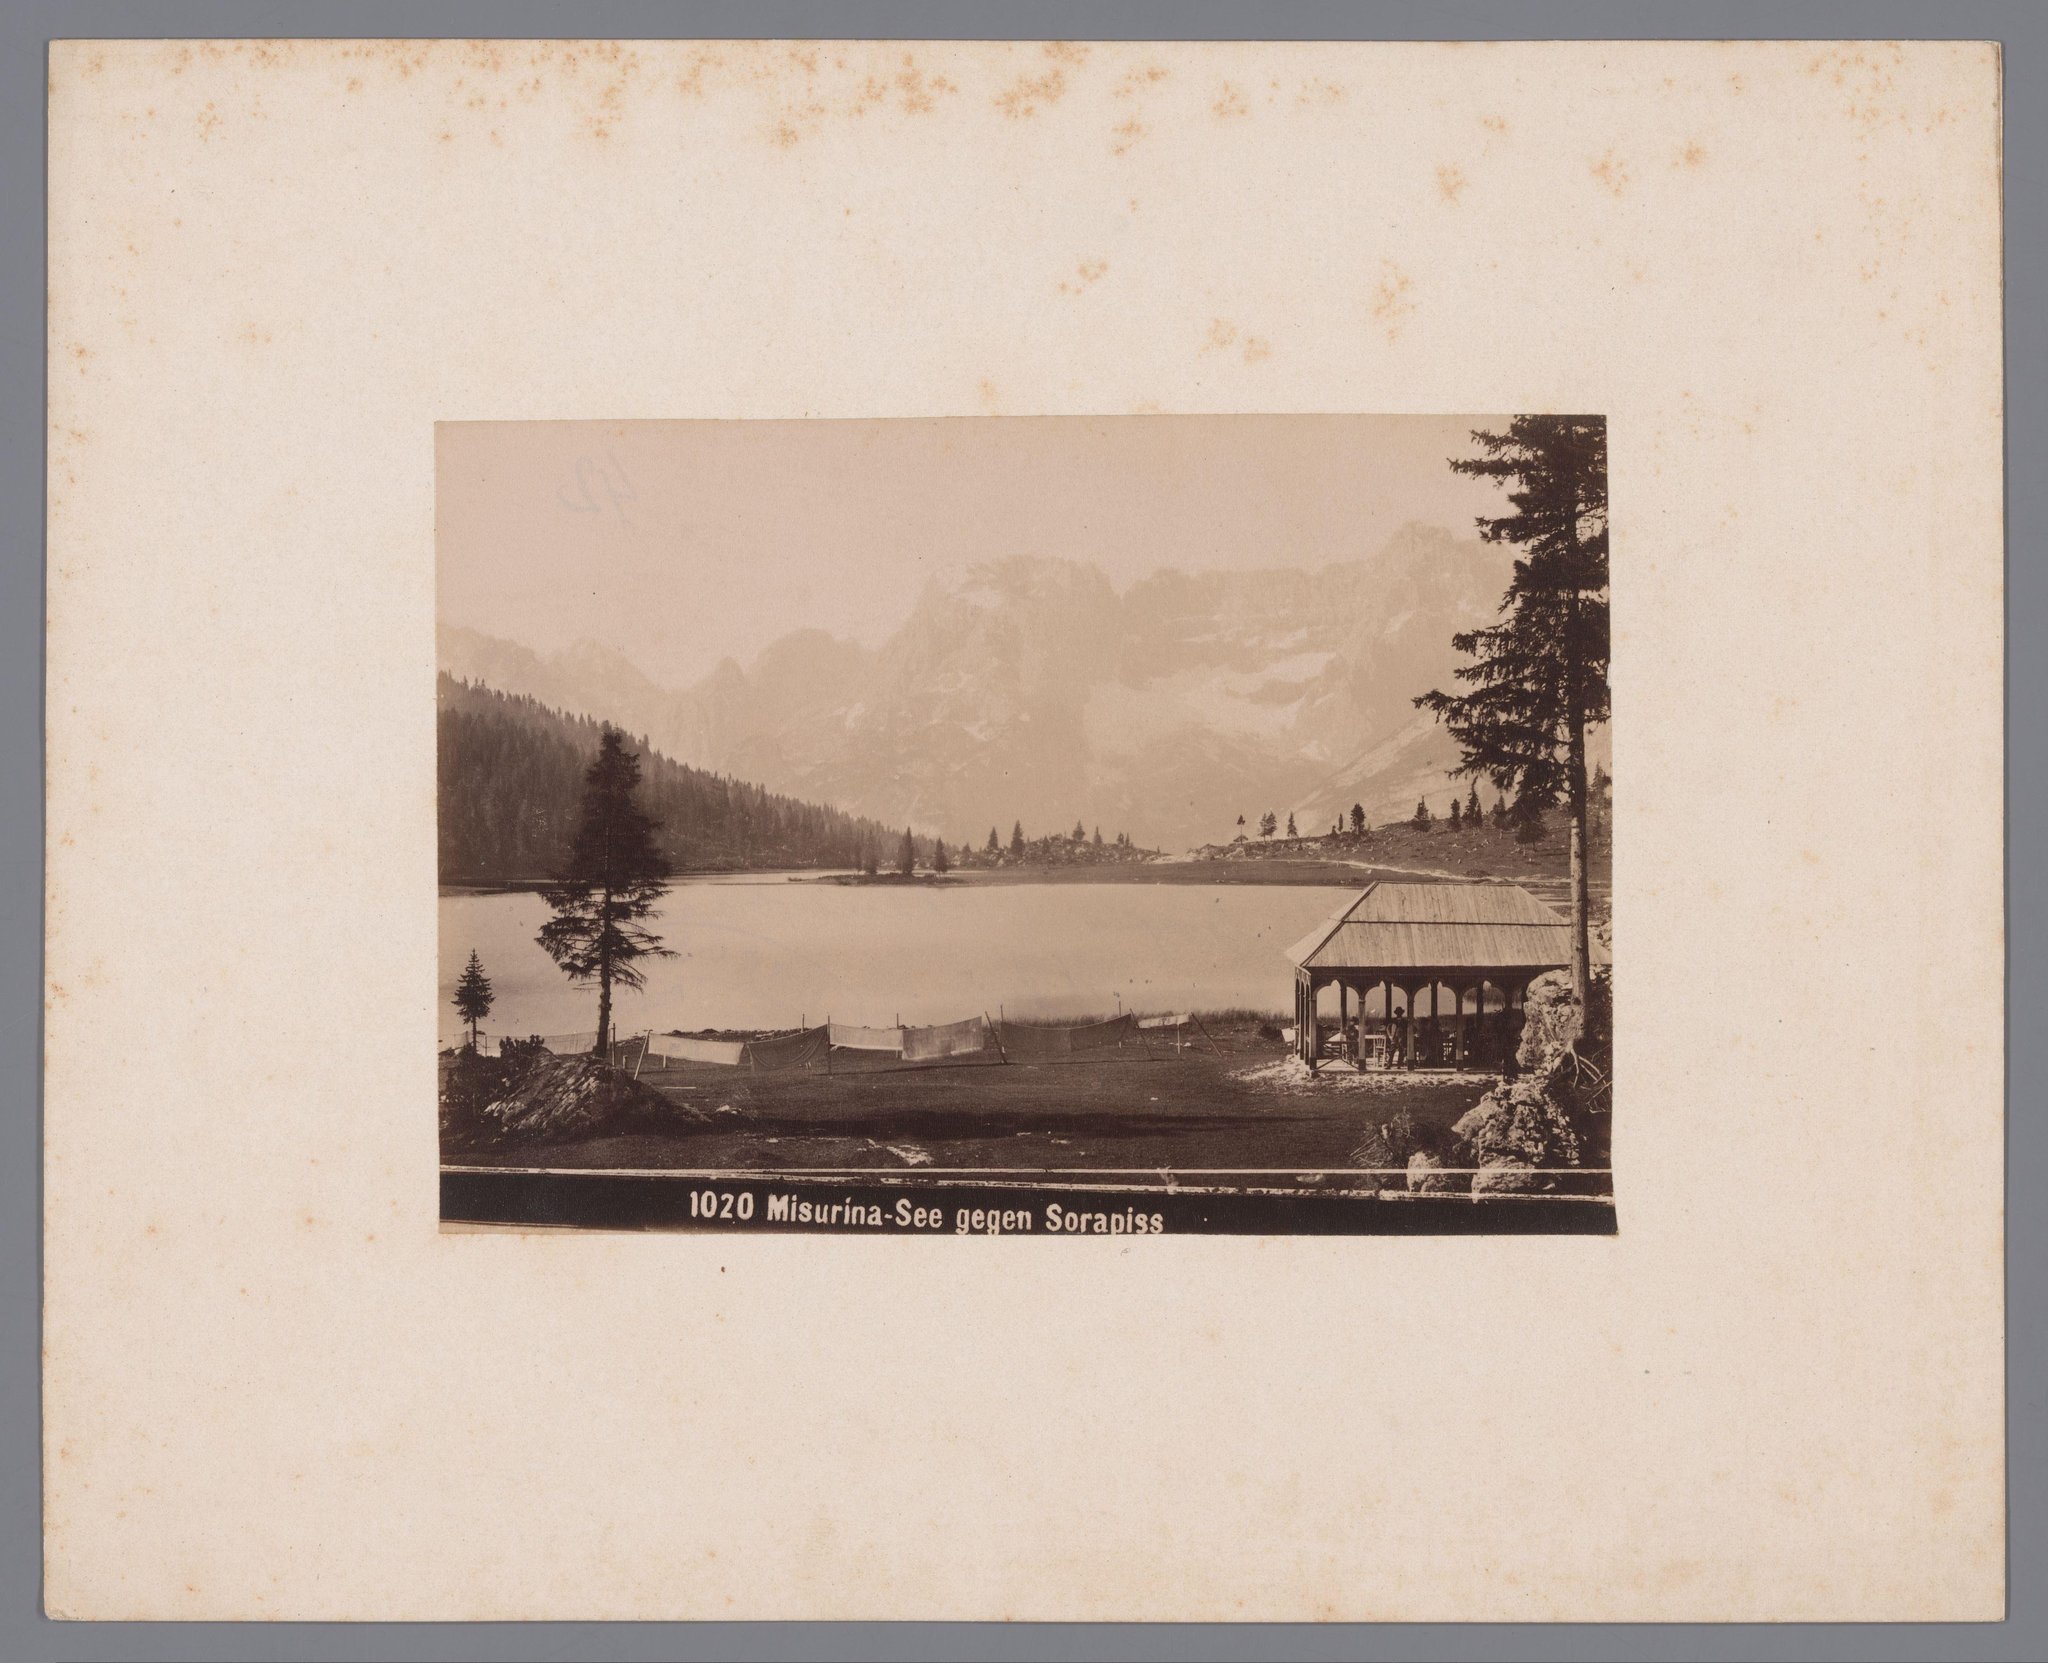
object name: photograph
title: Misurina-See gegen Sorapiss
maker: Anonymous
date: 1860-1900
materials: cardboard, paper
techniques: albumen print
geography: misurina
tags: lake, mountains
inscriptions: inscription: ‘42 Donderdag 18 Juli’, number: ‘1020’